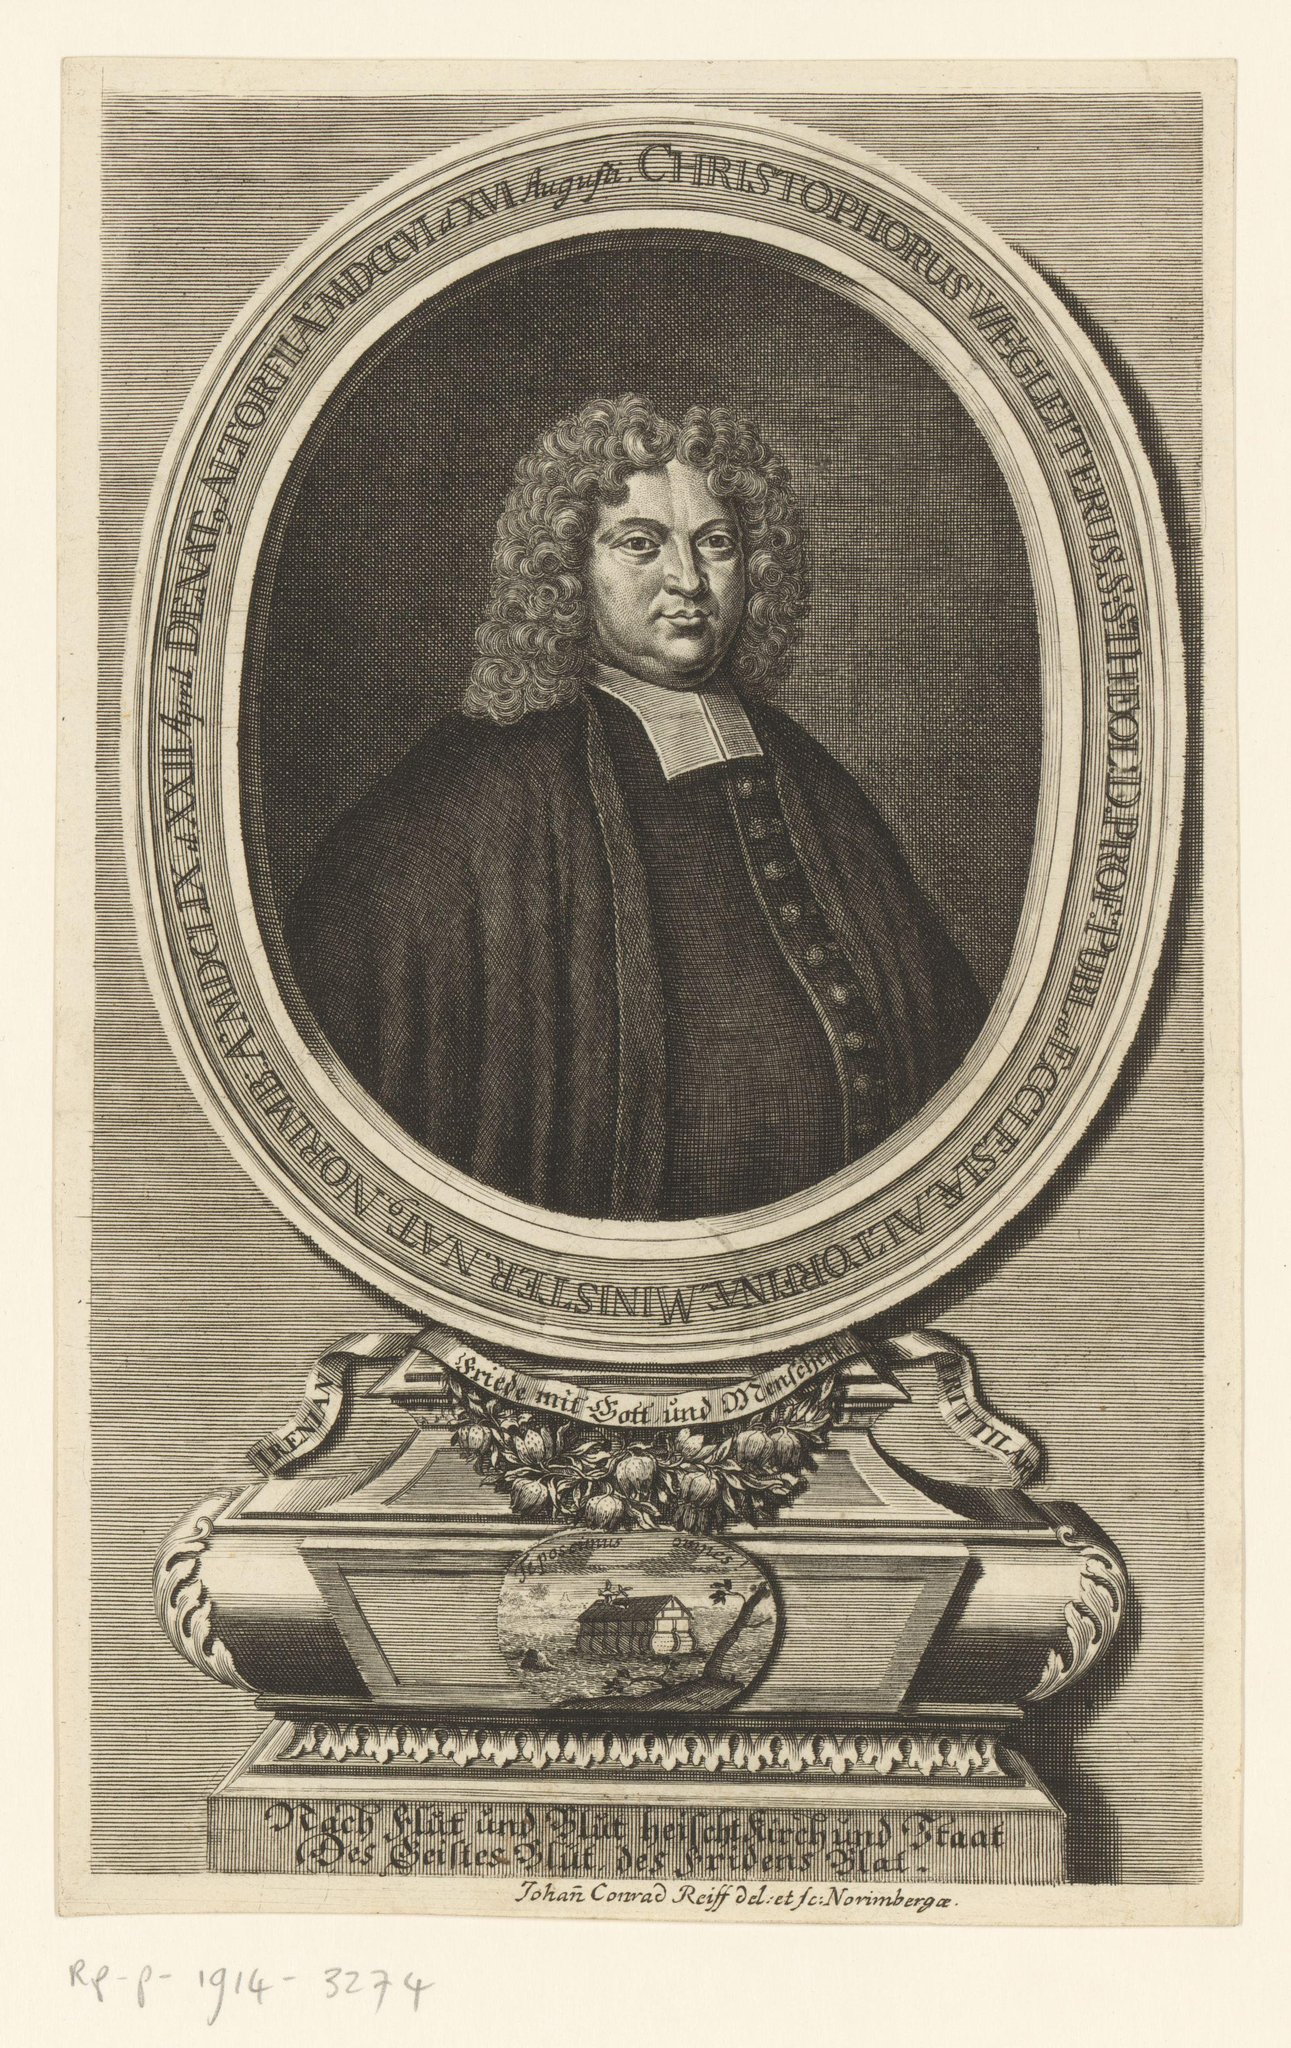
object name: print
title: Portret van Christoph Wegleiter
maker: johann conrad reiff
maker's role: print maker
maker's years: -1726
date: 1669-1726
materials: paper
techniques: engraving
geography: nuremberg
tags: christoph wegleiter, historical persons, abstract ideas and concepts (+ emblematical representation of concept)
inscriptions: collector's mark: Lugt 2228